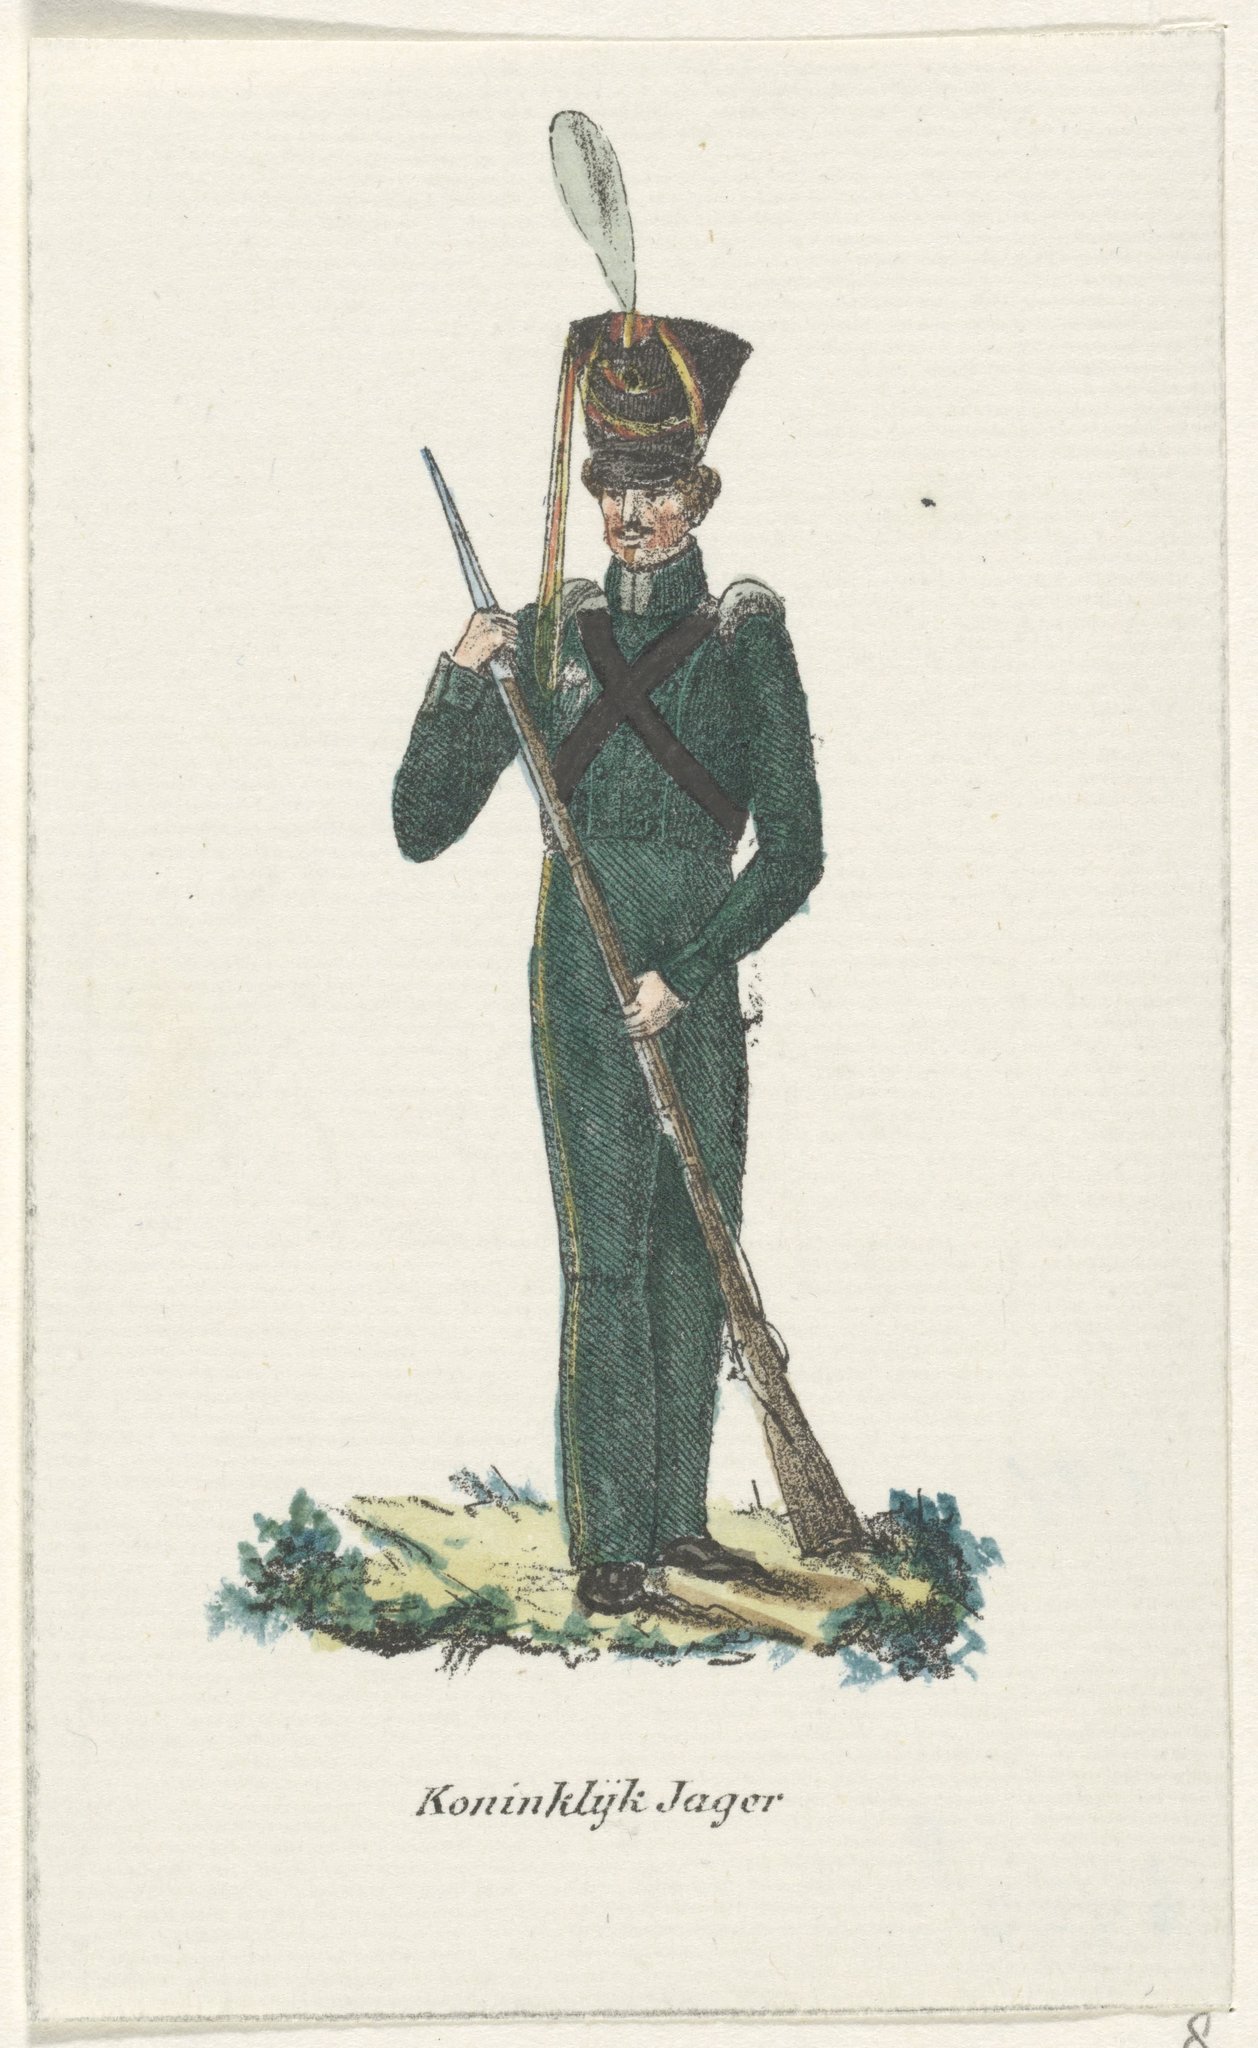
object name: print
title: 21 platen van Nederlandse uniformen ca. 1830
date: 1830-1835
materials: paper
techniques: hand coloring, lithograph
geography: amsterdam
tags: (military) uniforms, clothes, costume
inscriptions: collector's mark: Lugt 2228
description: Verkleinde kopieën naar de prenten van Houtman e.a. in FMH 6481. Muller beschrijft een onversneden compleet blad in de collectie Van Gijn waarop de namen van de prentmaker en de uitgever vermeld staan.